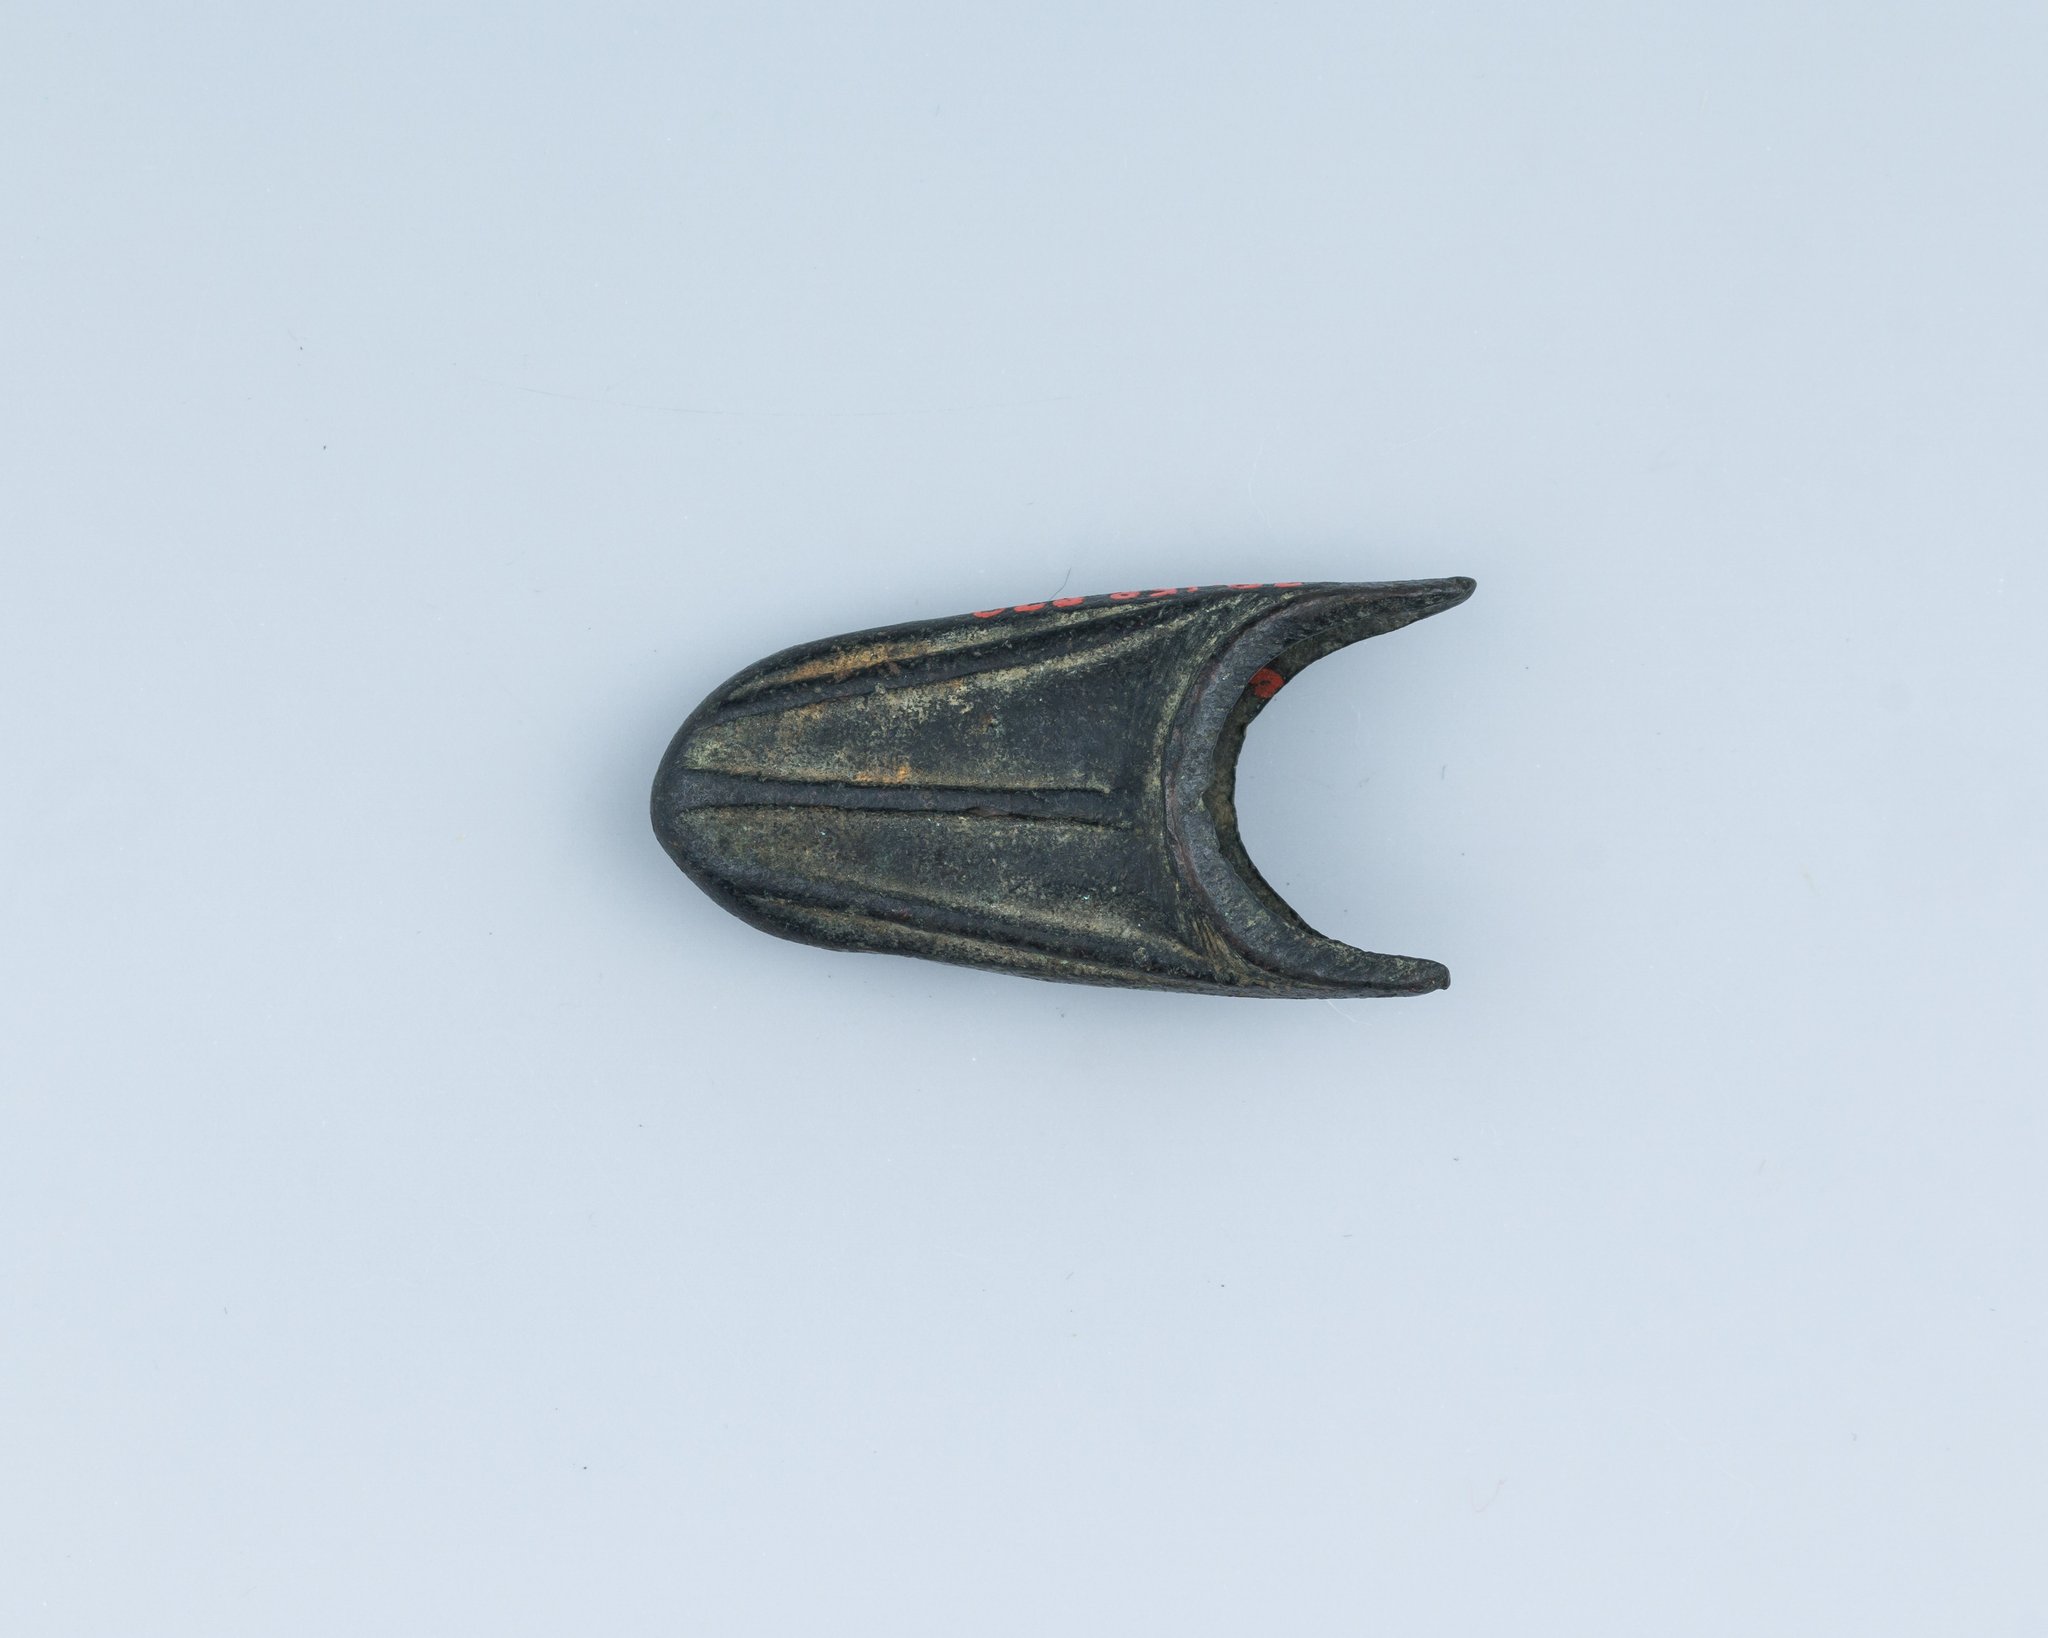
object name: mordant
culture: european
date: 1401-1700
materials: bronze